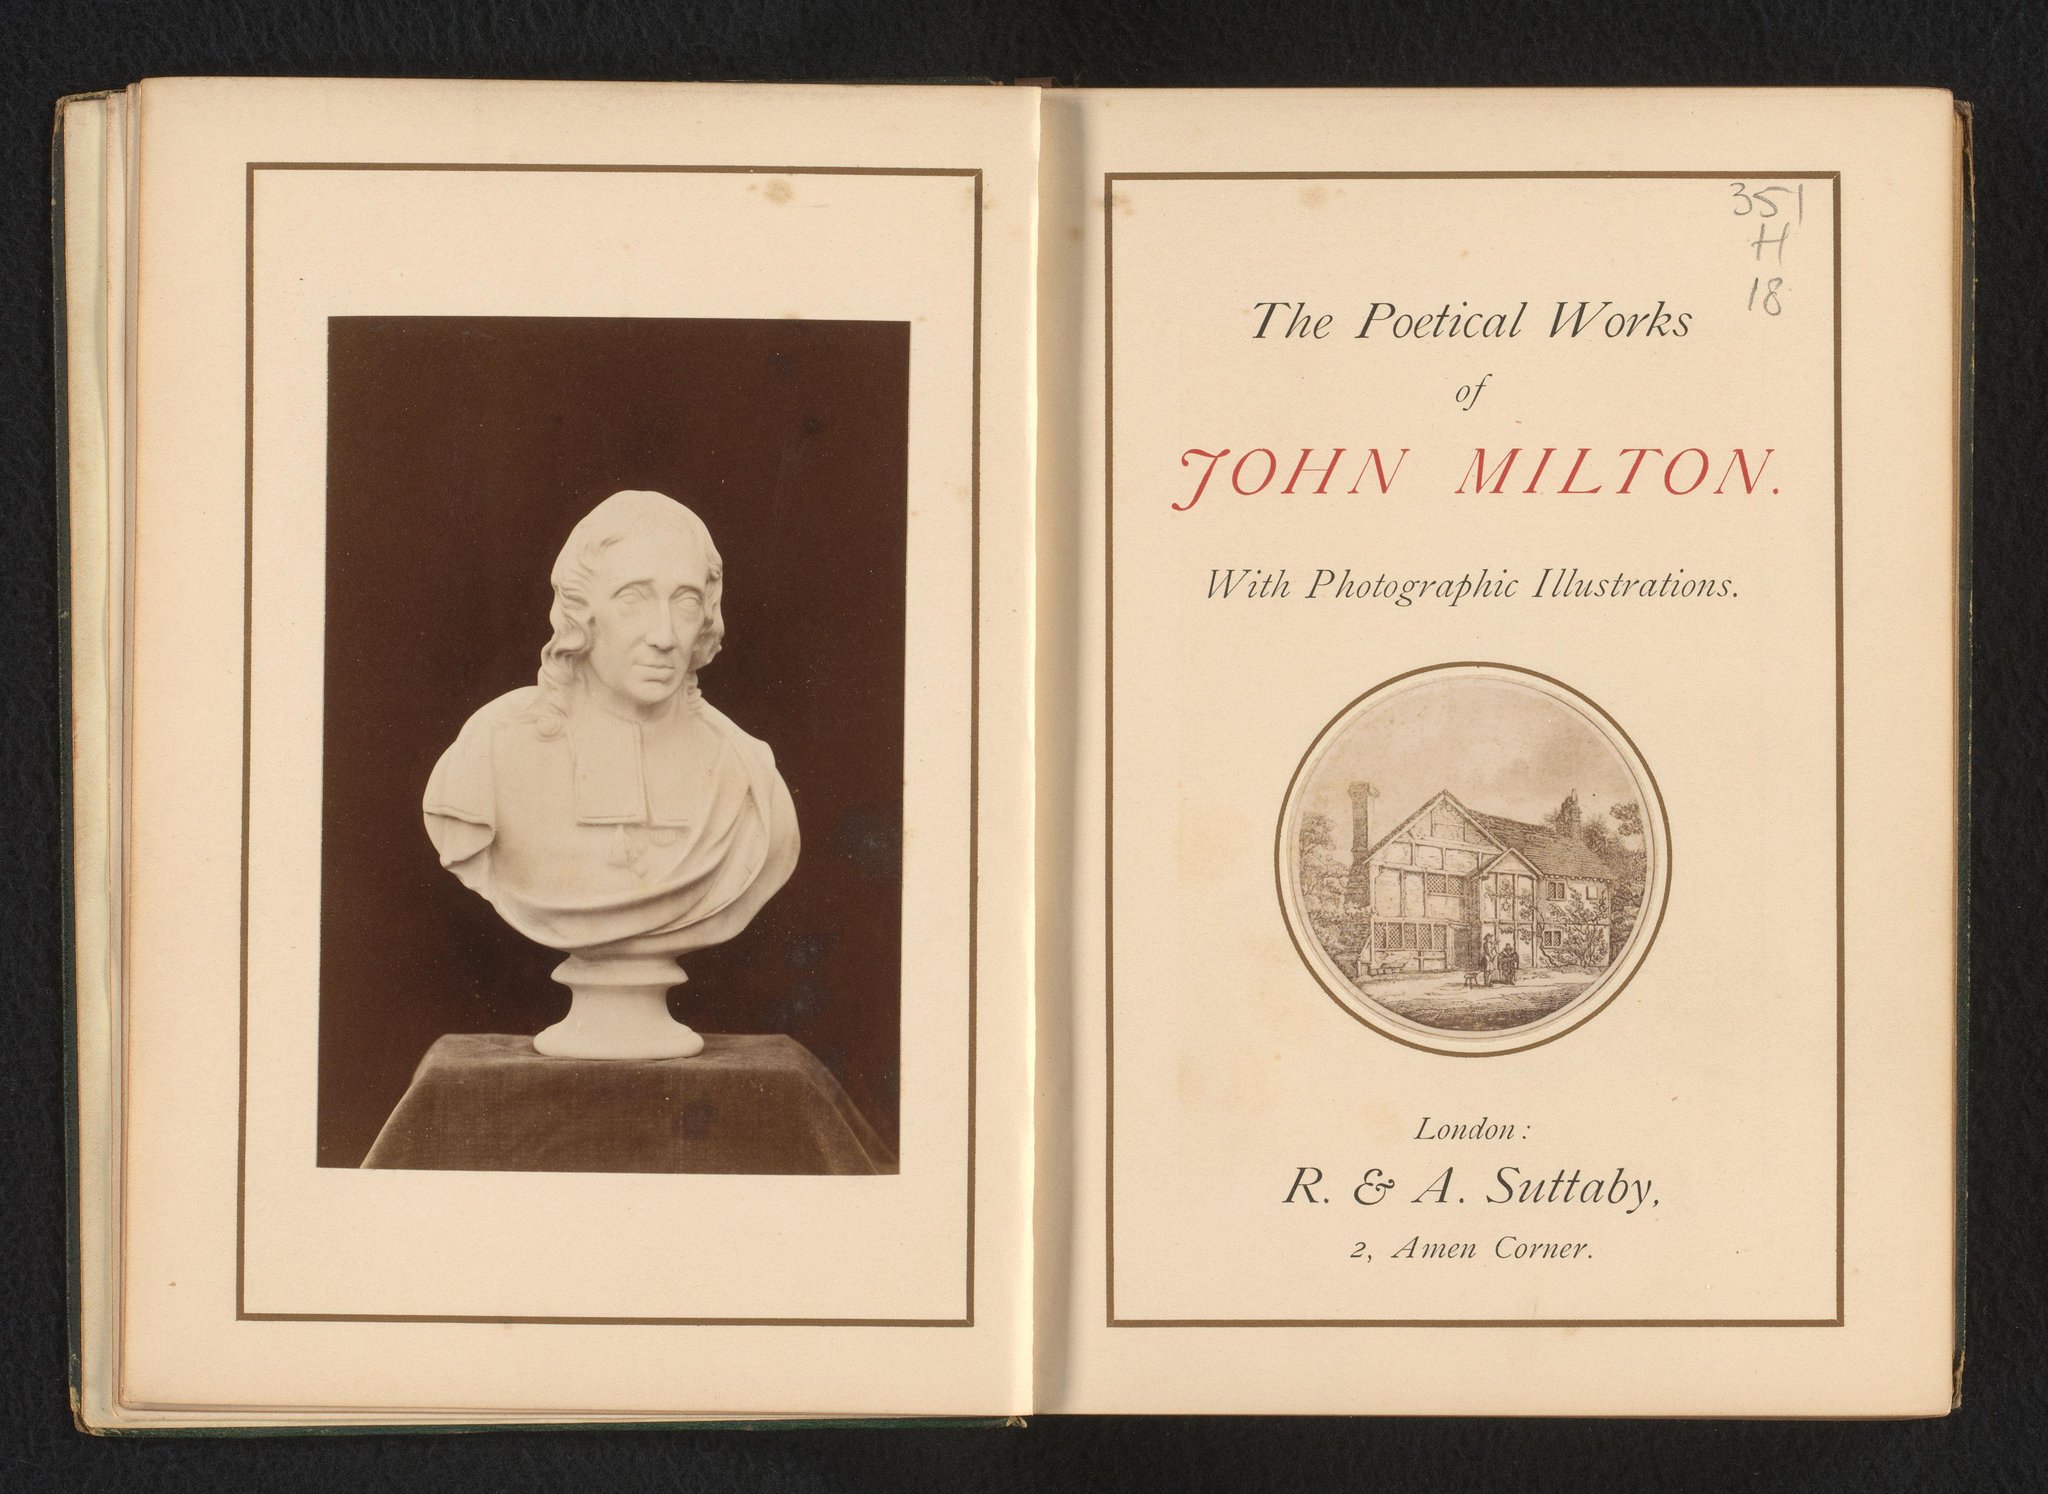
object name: page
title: Sculptuur met een buste van de dichter John Milton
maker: Anonymous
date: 1866-1890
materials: paper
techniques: albumen print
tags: london, john milton, portrait of a writer, piece of sculpture, reproduction of a piece of sculpture